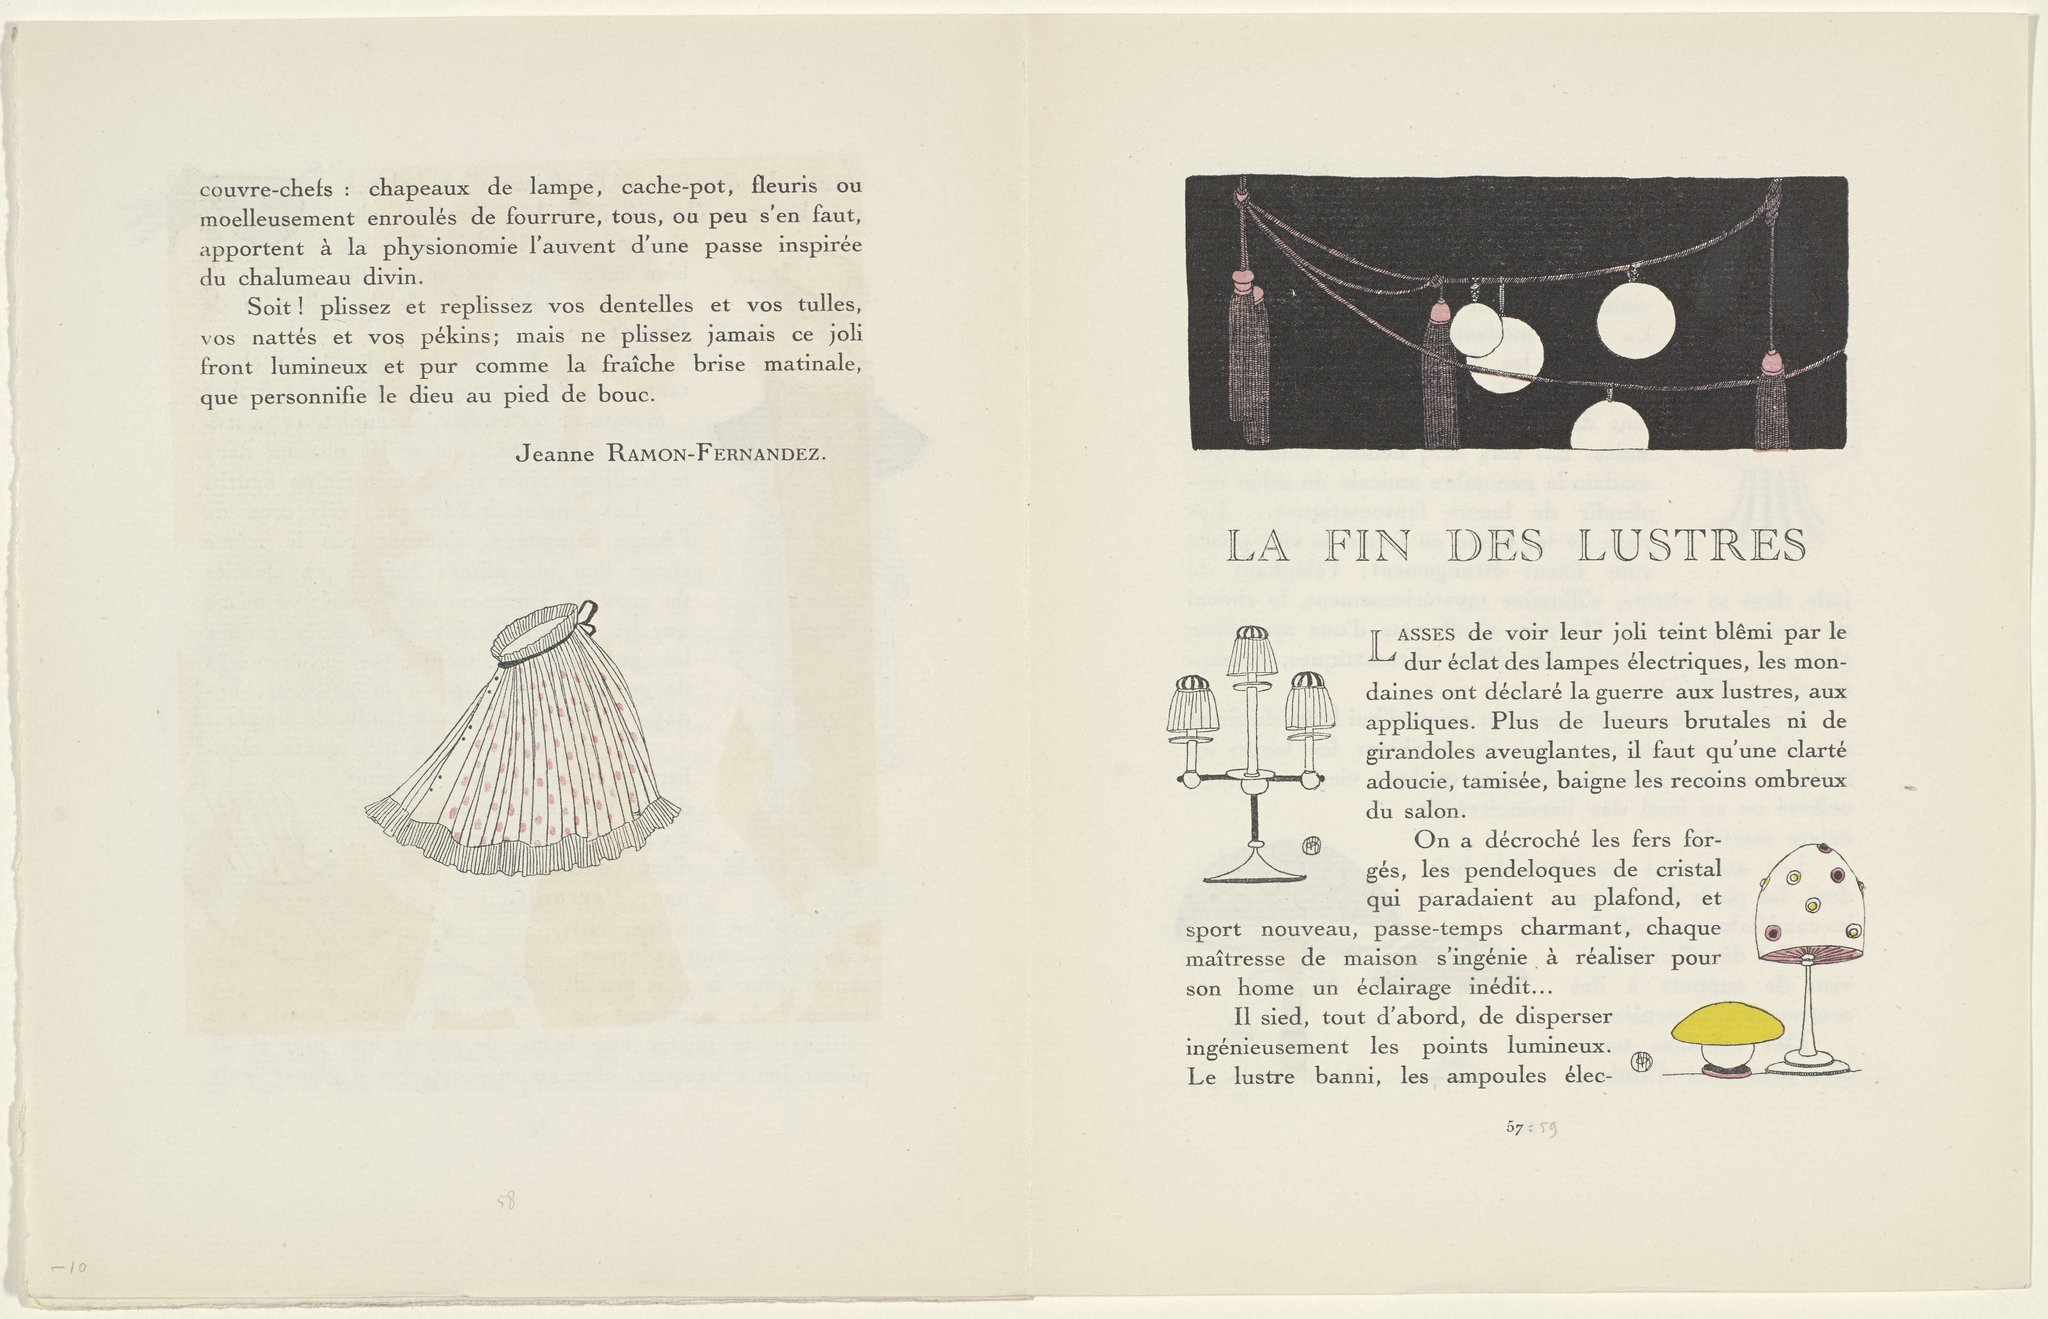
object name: fashion print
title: Gazette du Bon Ton, 1914 - No. 2: p. 58: Les Plissés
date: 1914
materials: paper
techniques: hand coloring, letterpress printing, lithograph, pochoir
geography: paris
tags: fashion plates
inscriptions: date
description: Les Plissés. Tekst van Jeanne Ramon-Fernandez, met illustratie van een geplisseerde rok. Pag. 58 in Gazette du Bon Ton 1914, No. 2.